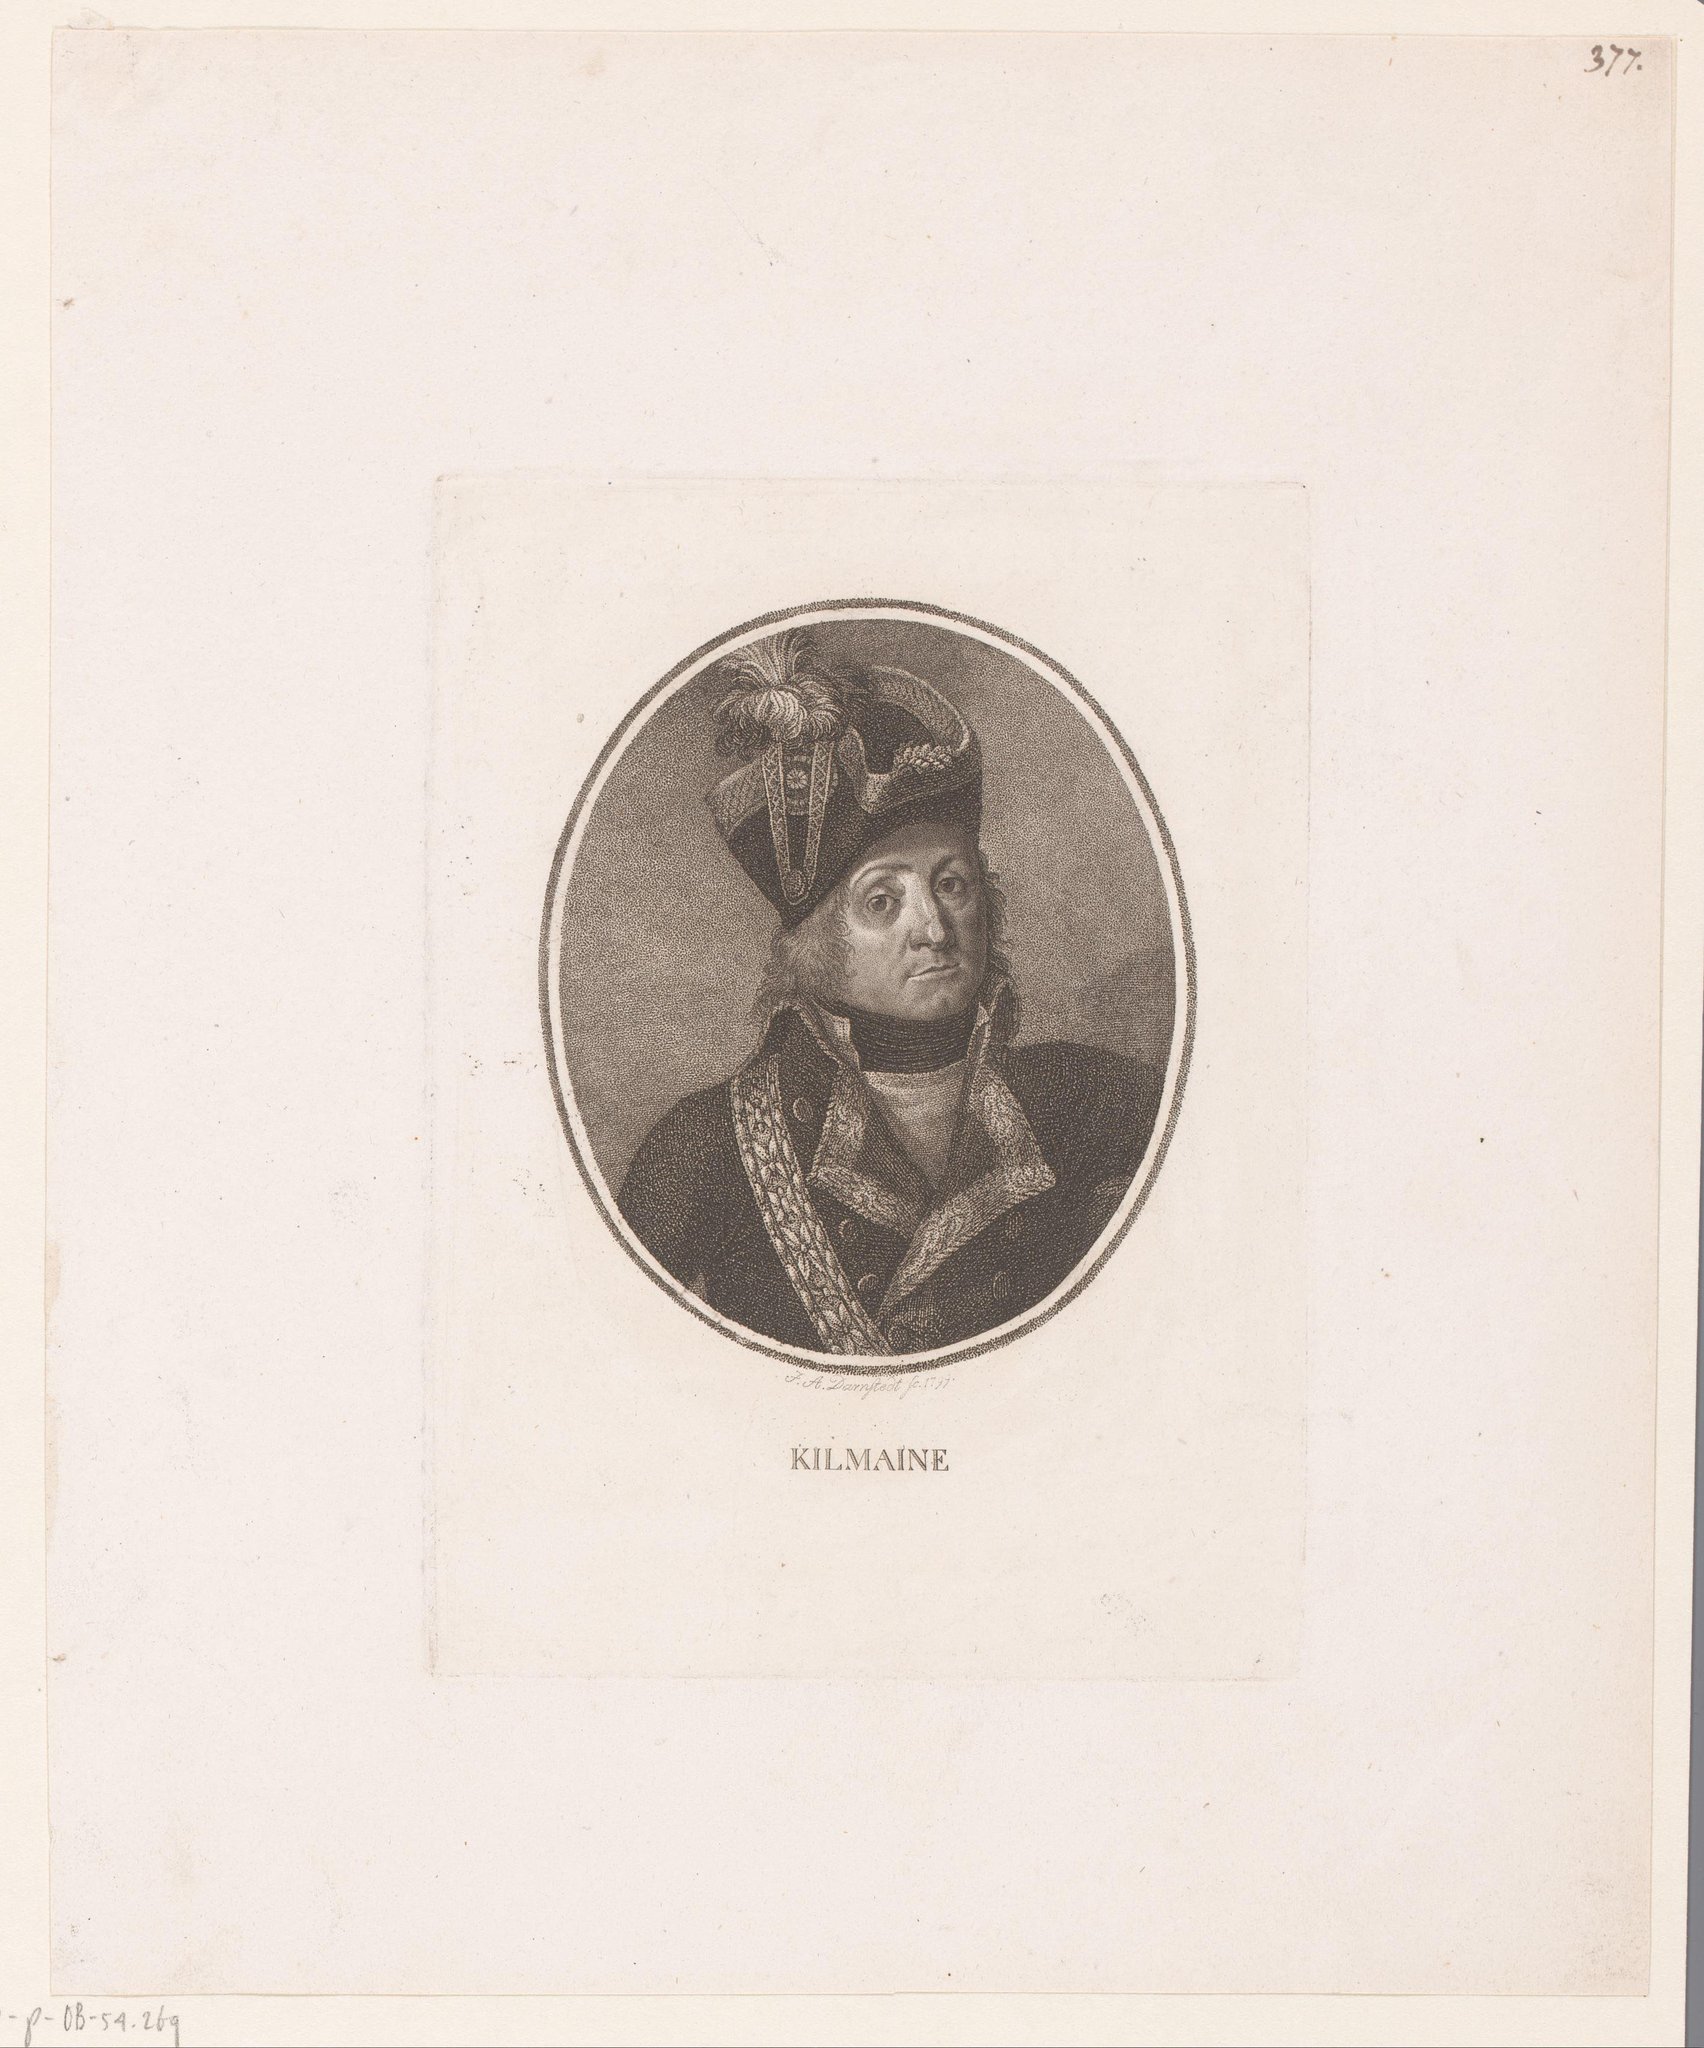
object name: print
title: Portret van Charles Edward Jennings de Kilmaine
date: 1799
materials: paper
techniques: engraving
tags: paris, historical persons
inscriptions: collector's mark: Lugt 2228